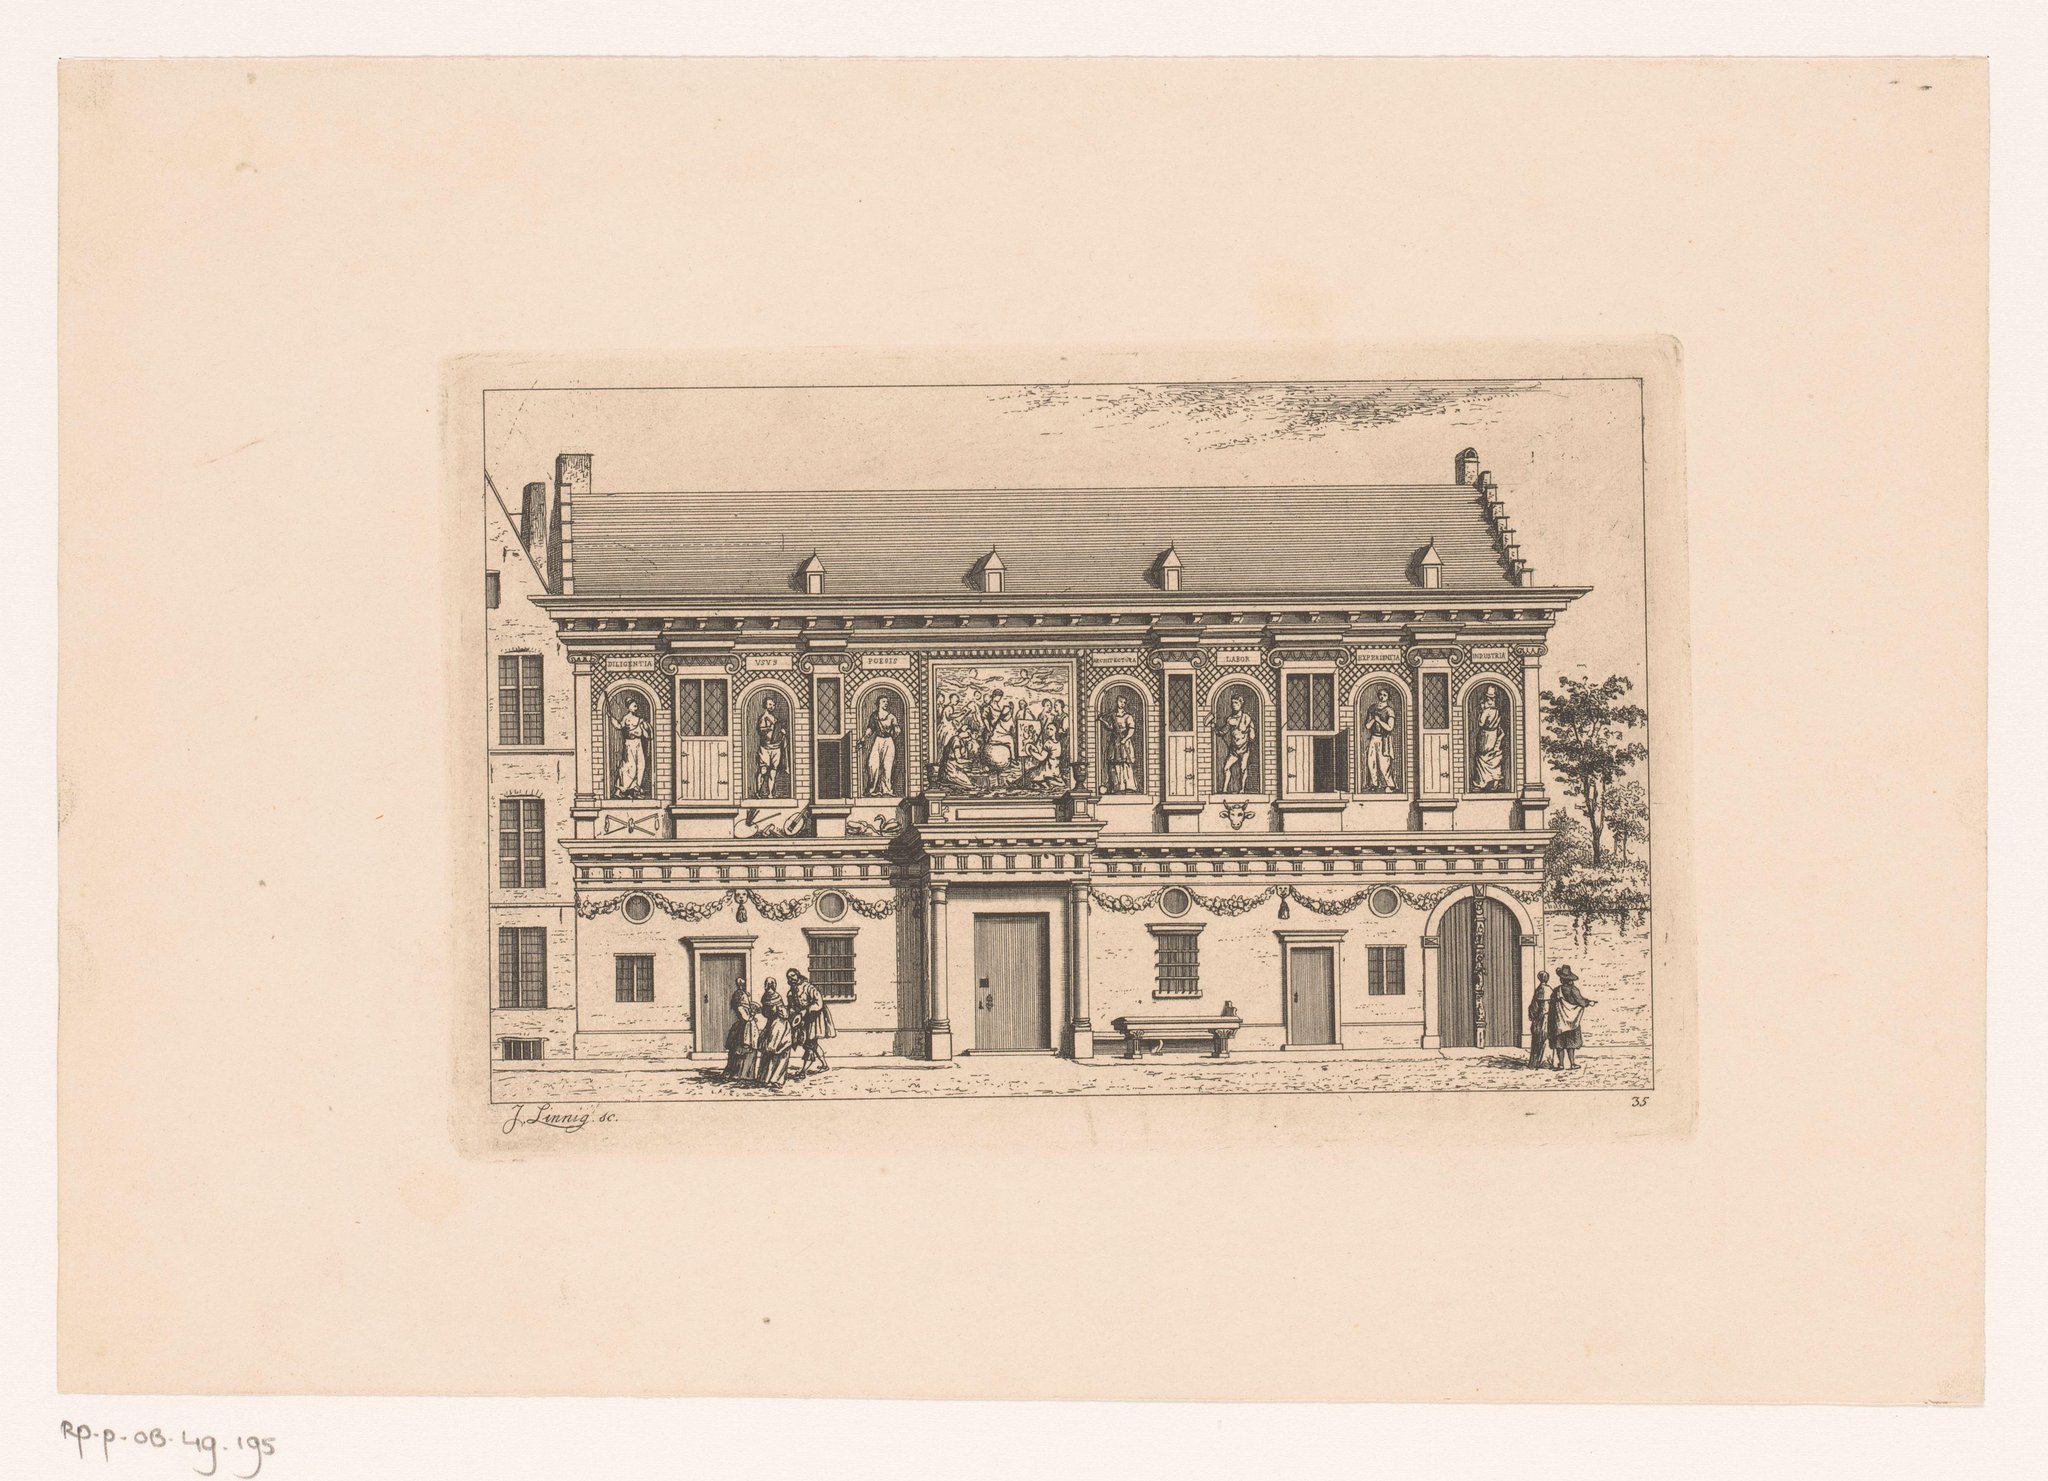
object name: book illustration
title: Gezicht op het huis van Frans Floris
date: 1868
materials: paper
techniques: etching, intaglio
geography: antwerp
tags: antwerp, print maker, draughtsman, frans floris (i), façade (of house or building)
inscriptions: collector's mark: Lugt 2228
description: Prent uit: Mertens, F.H. Album historique de la ville d'Anvers [...]. Antwerpen: J.E. Buschmann, 1868.